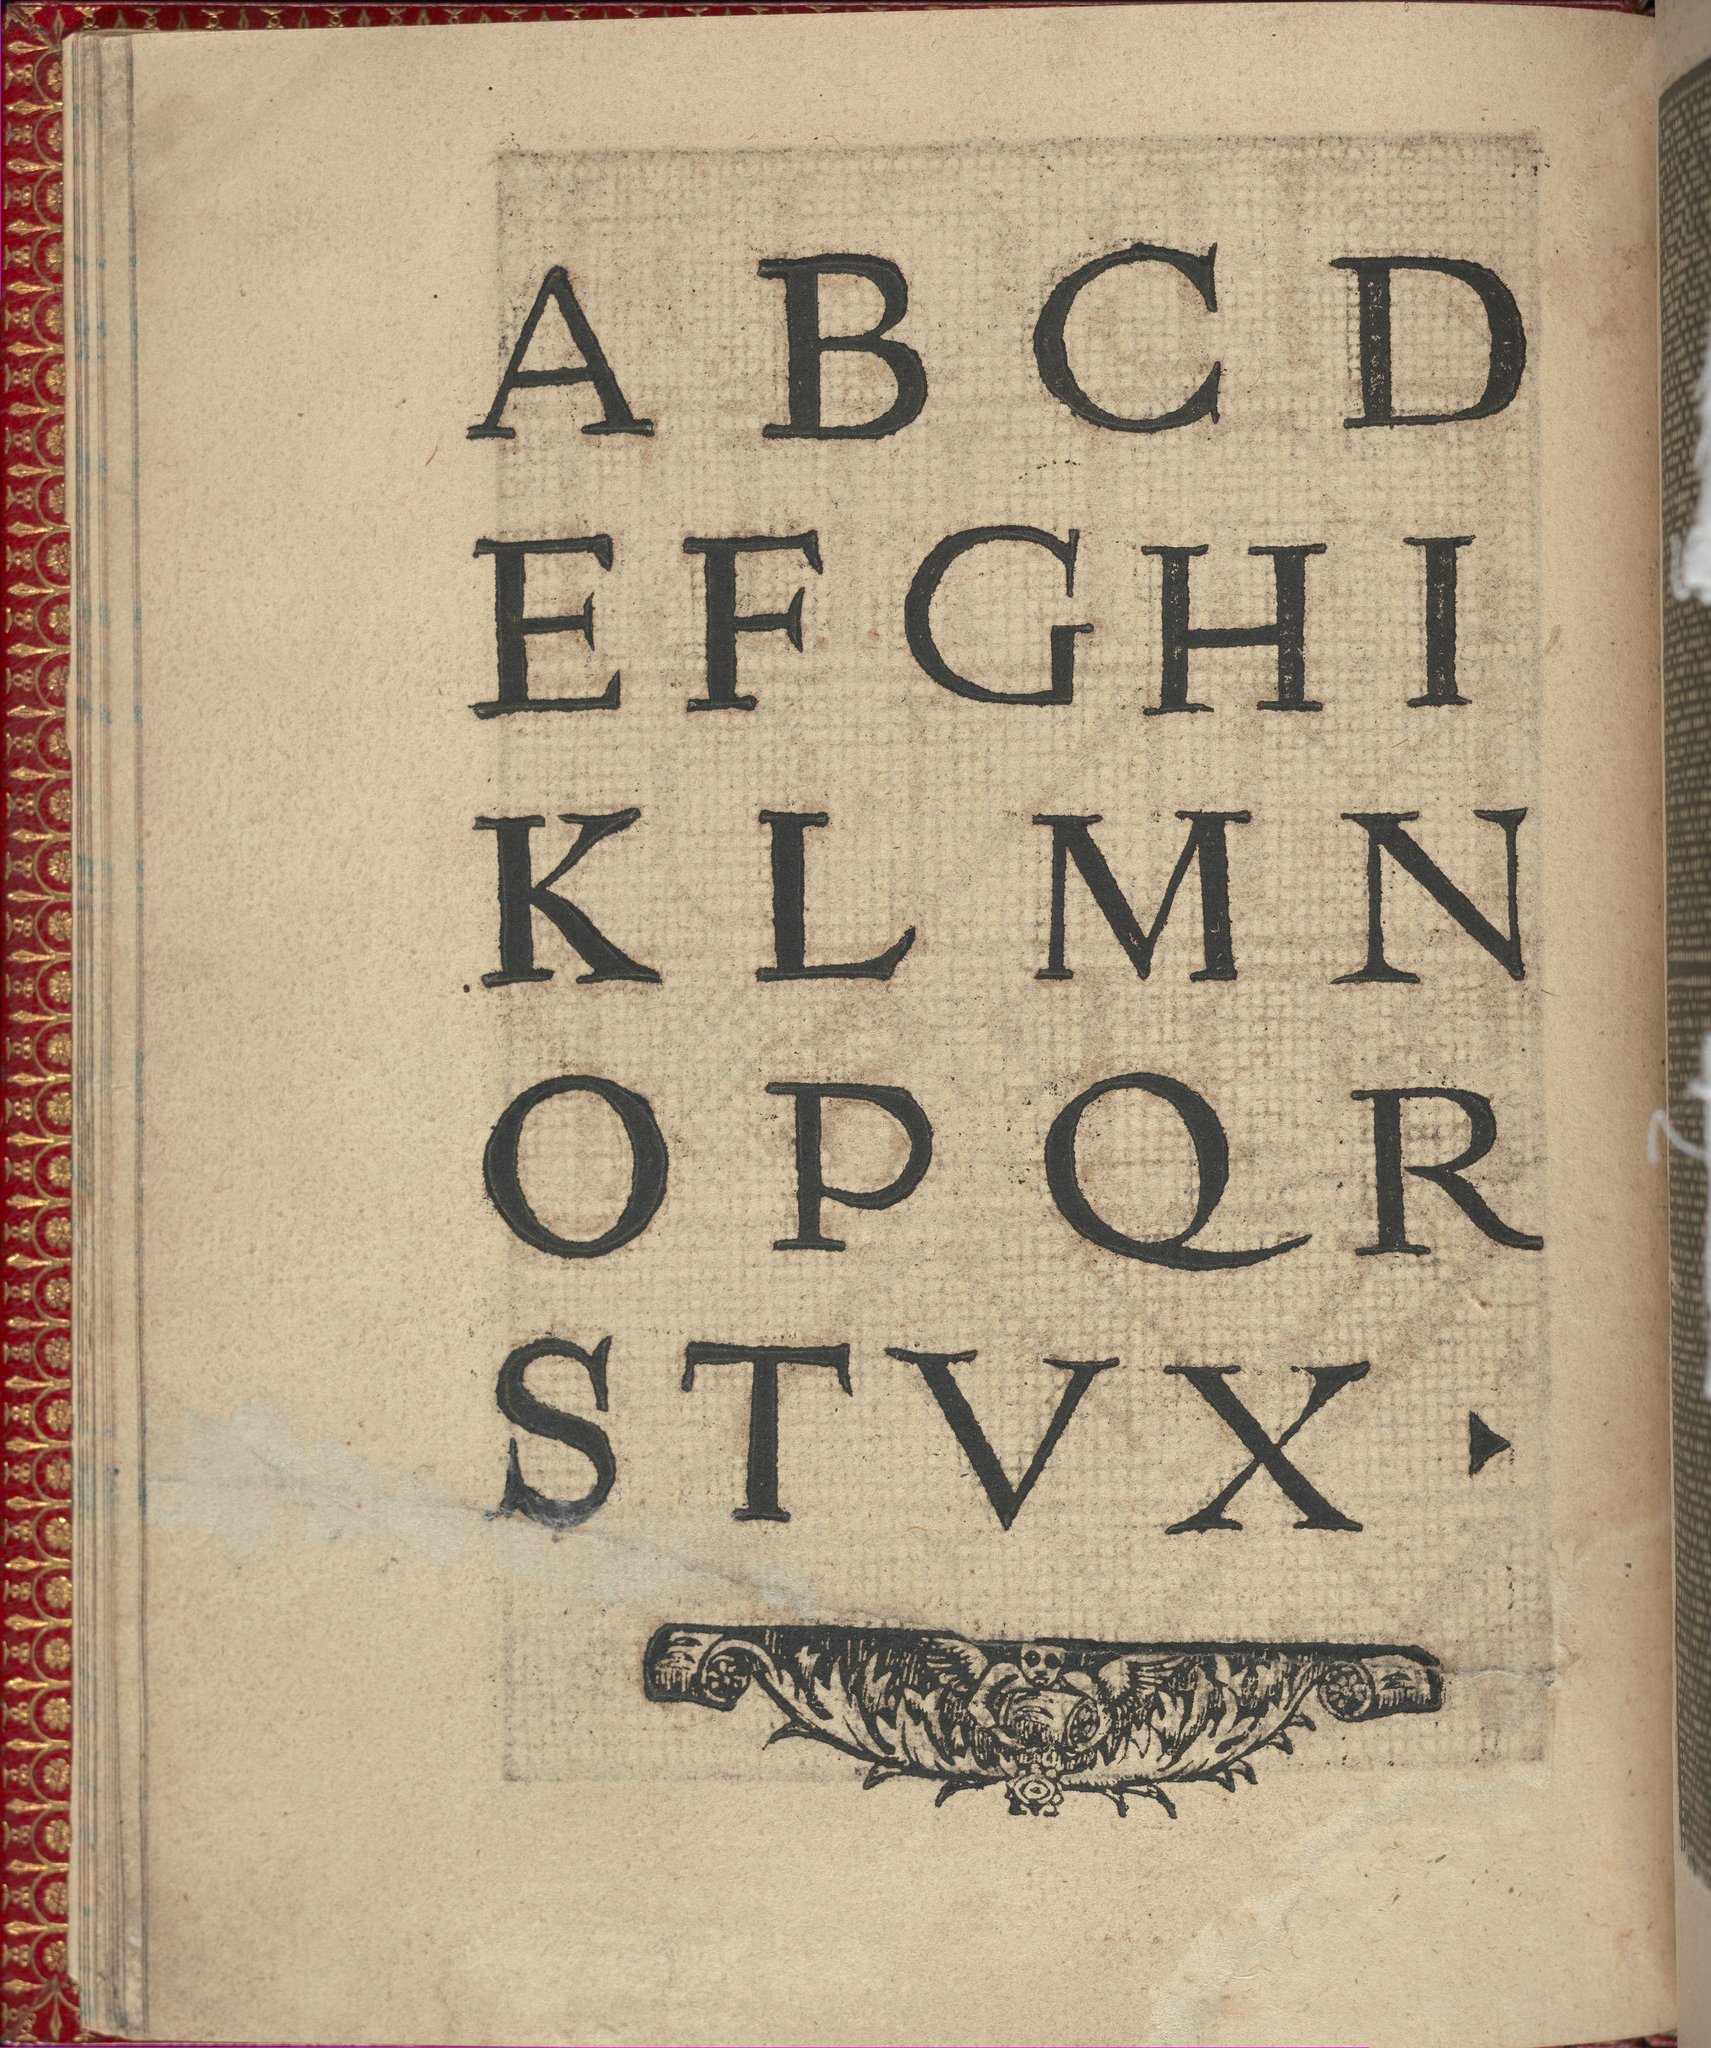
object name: book print ornament architecture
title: Ce est ung tractat de la noble art de leguille ascavoir ouvraiges de spaigne... page 8 (recto)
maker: willem vosterman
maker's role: printer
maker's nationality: netherlandish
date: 1527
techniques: woodcut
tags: ornament